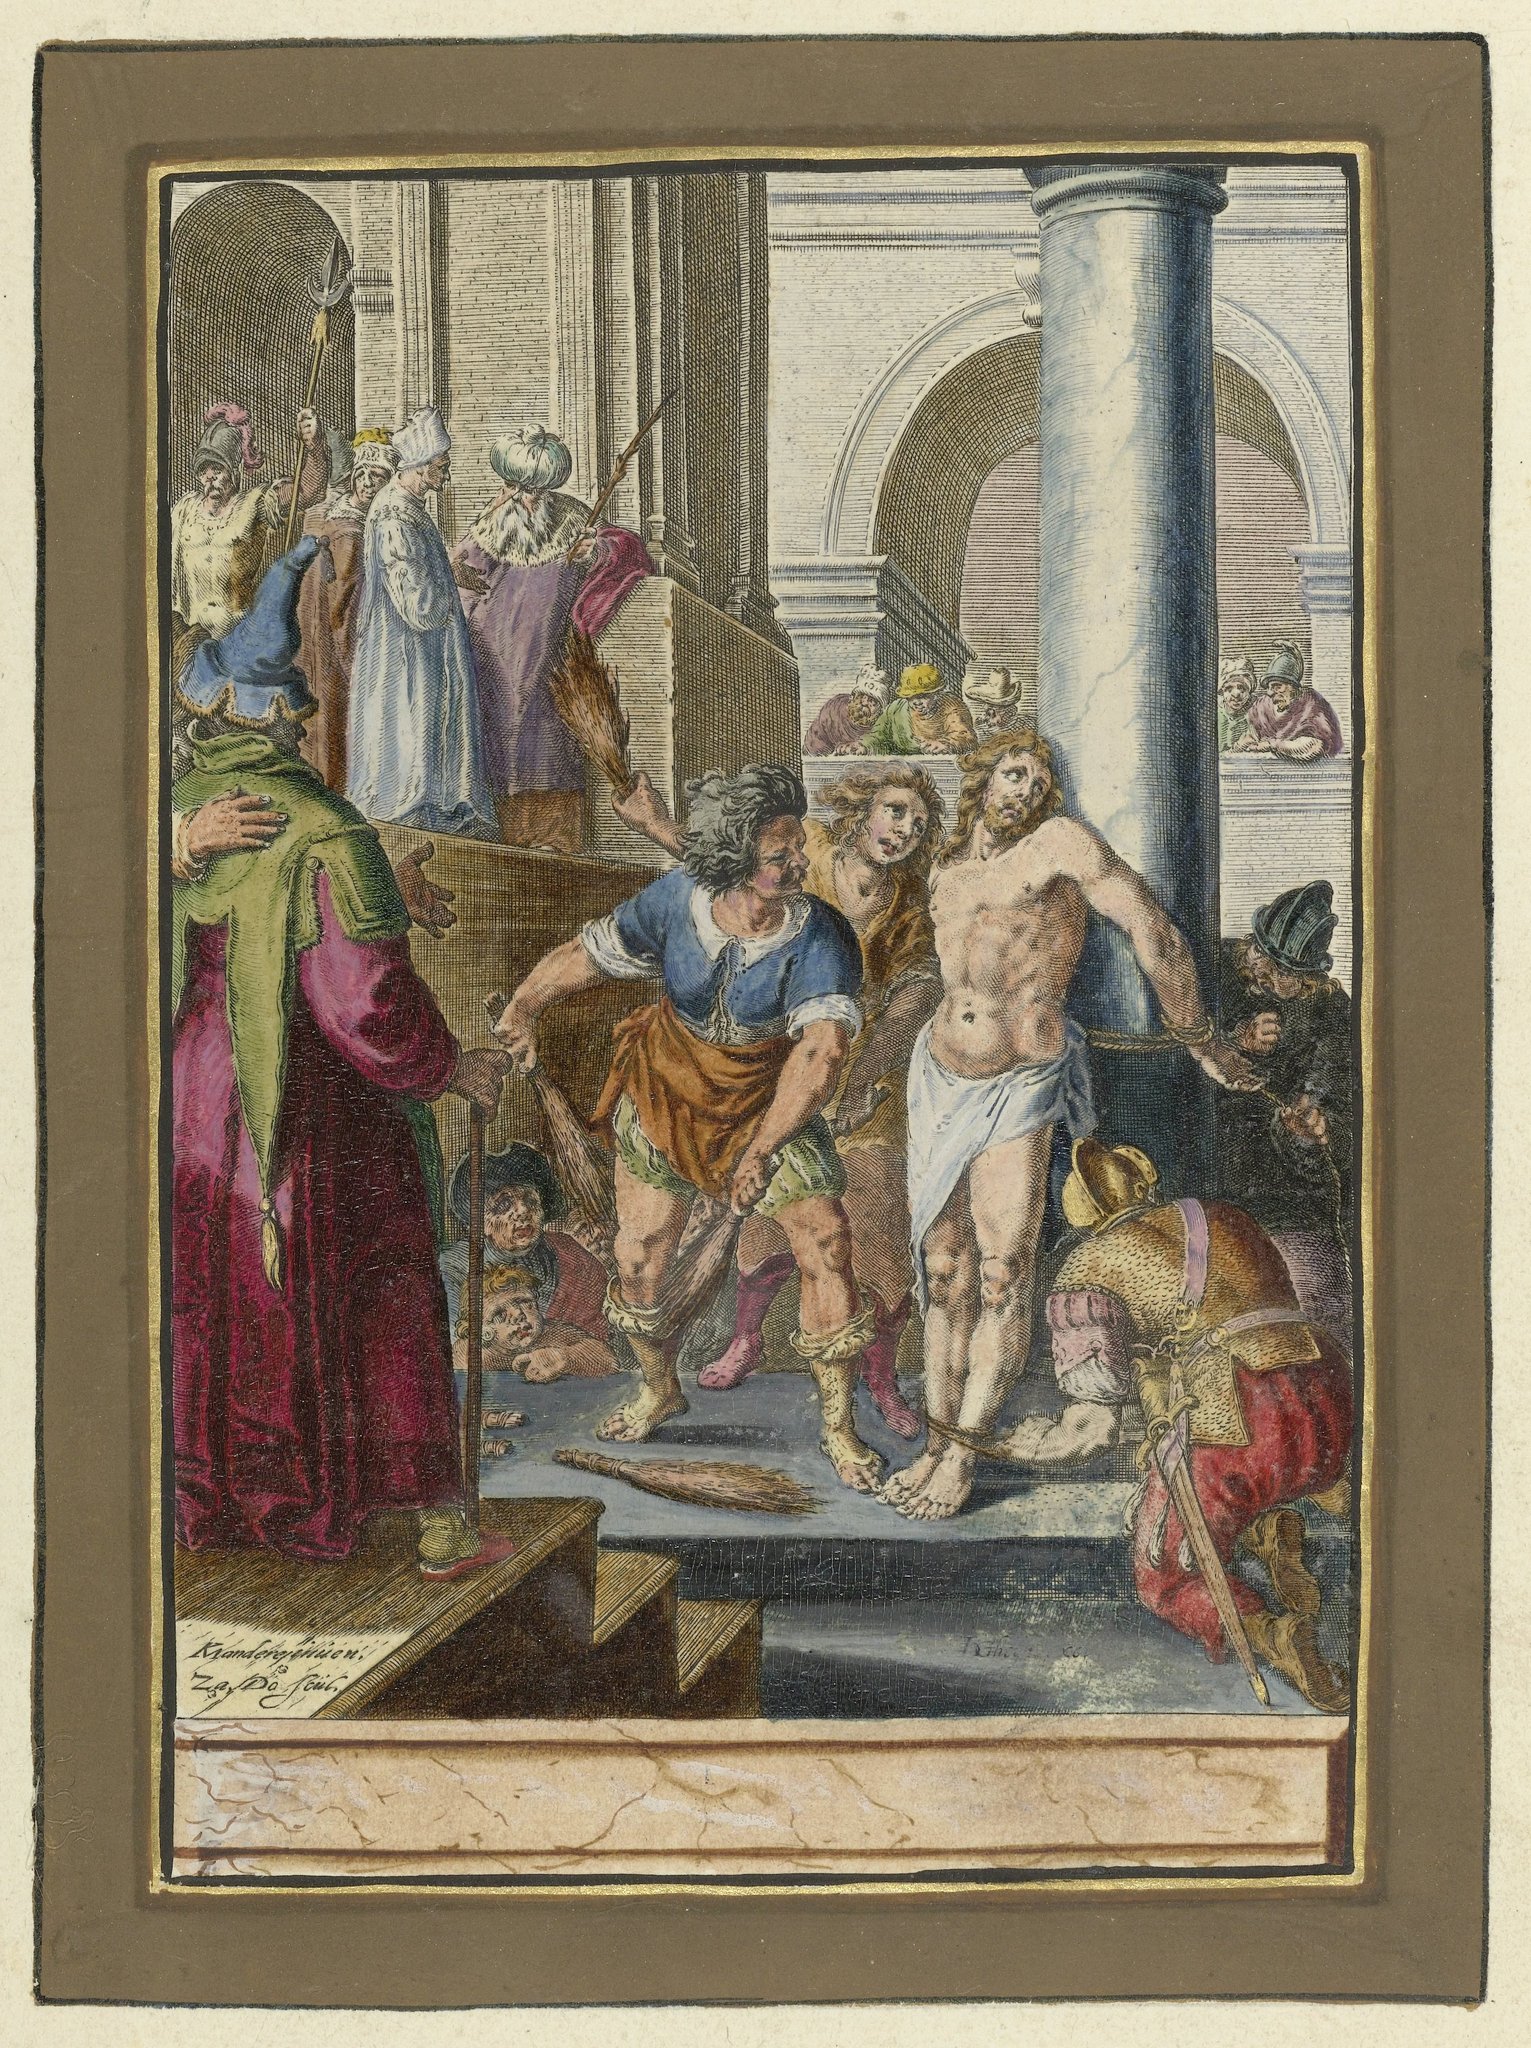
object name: print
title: Passie van Christus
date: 1596-1598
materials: paper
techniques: engraving, hand coloring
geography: leiden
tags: flagellation by soldiers, christ usually tied to a column (matthew 27:26; mark 15:15; john 19:1)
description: Christus wordt gegeseld door soldaten terwijl hij vastgebonden staat aan een pilaar in een tempelachtige ruimte. Zesde prent in een serie voorstellingen van het Lijdensverhaal. Prent maakt deel uit van een album.